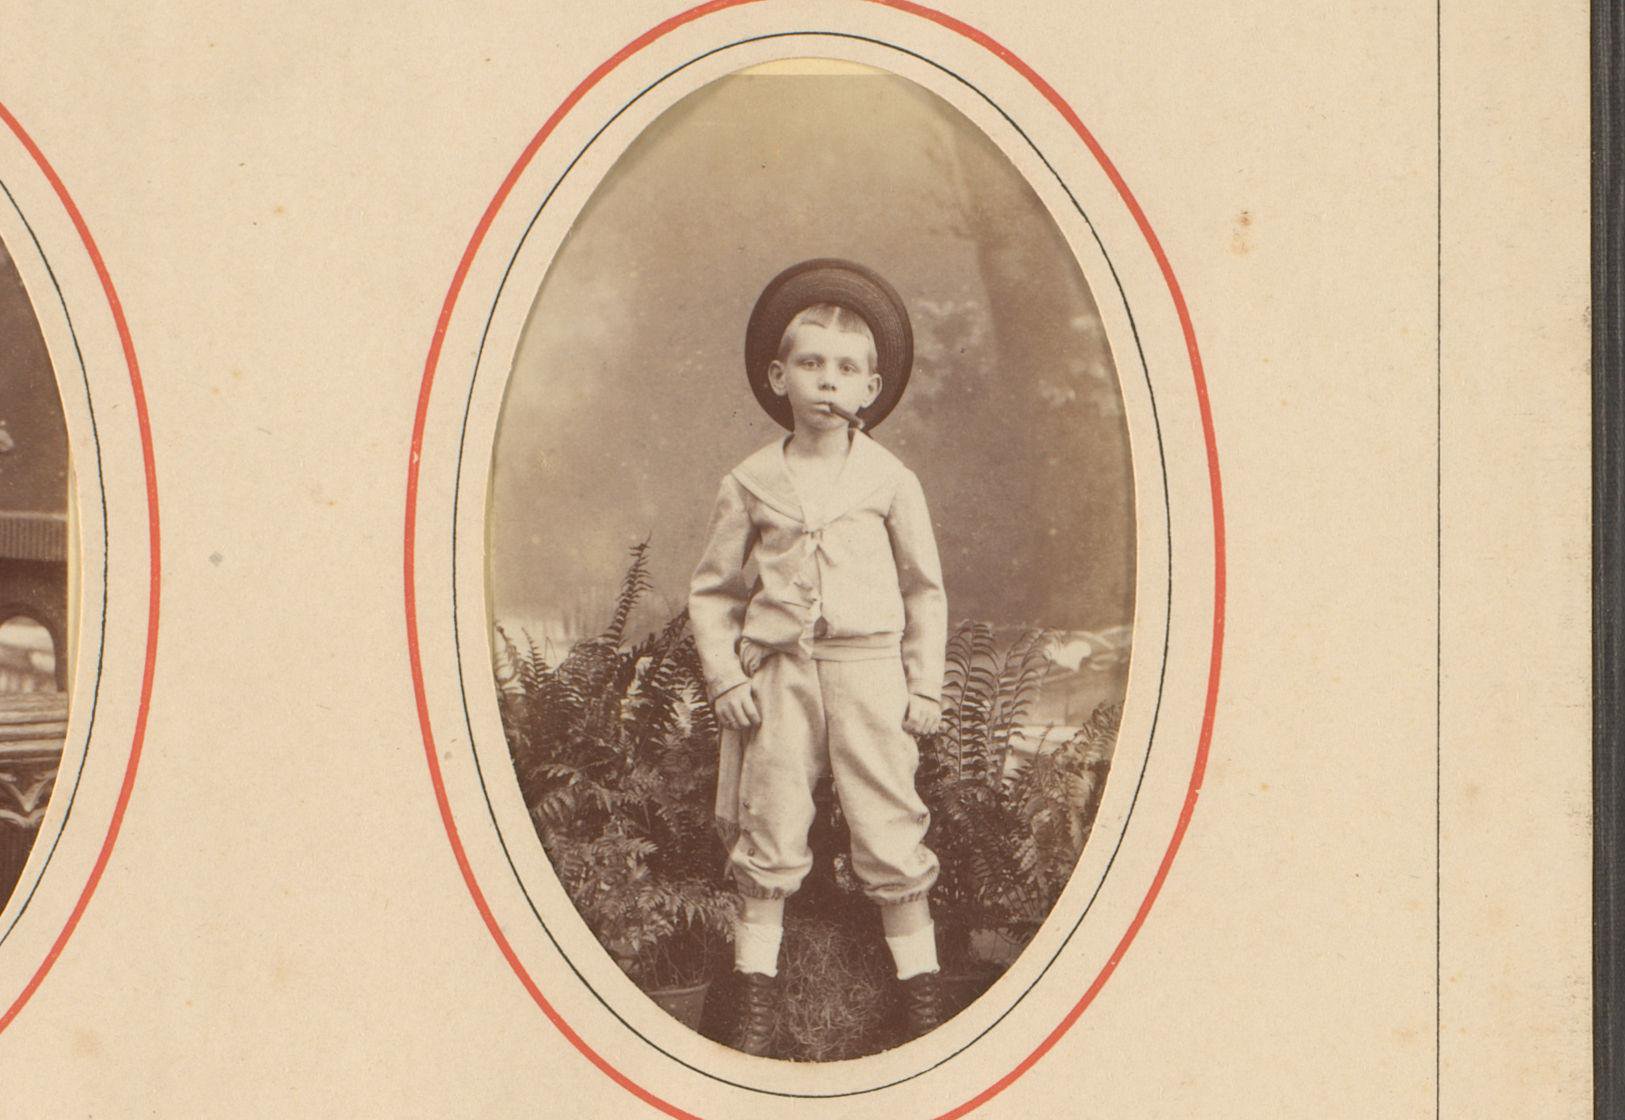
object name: photograph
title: Portret van een onbekende jongen met sigaar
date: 1870-1890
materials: cardboard, paper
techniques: albumen print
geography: batavia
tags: anonymous historical person portrayed